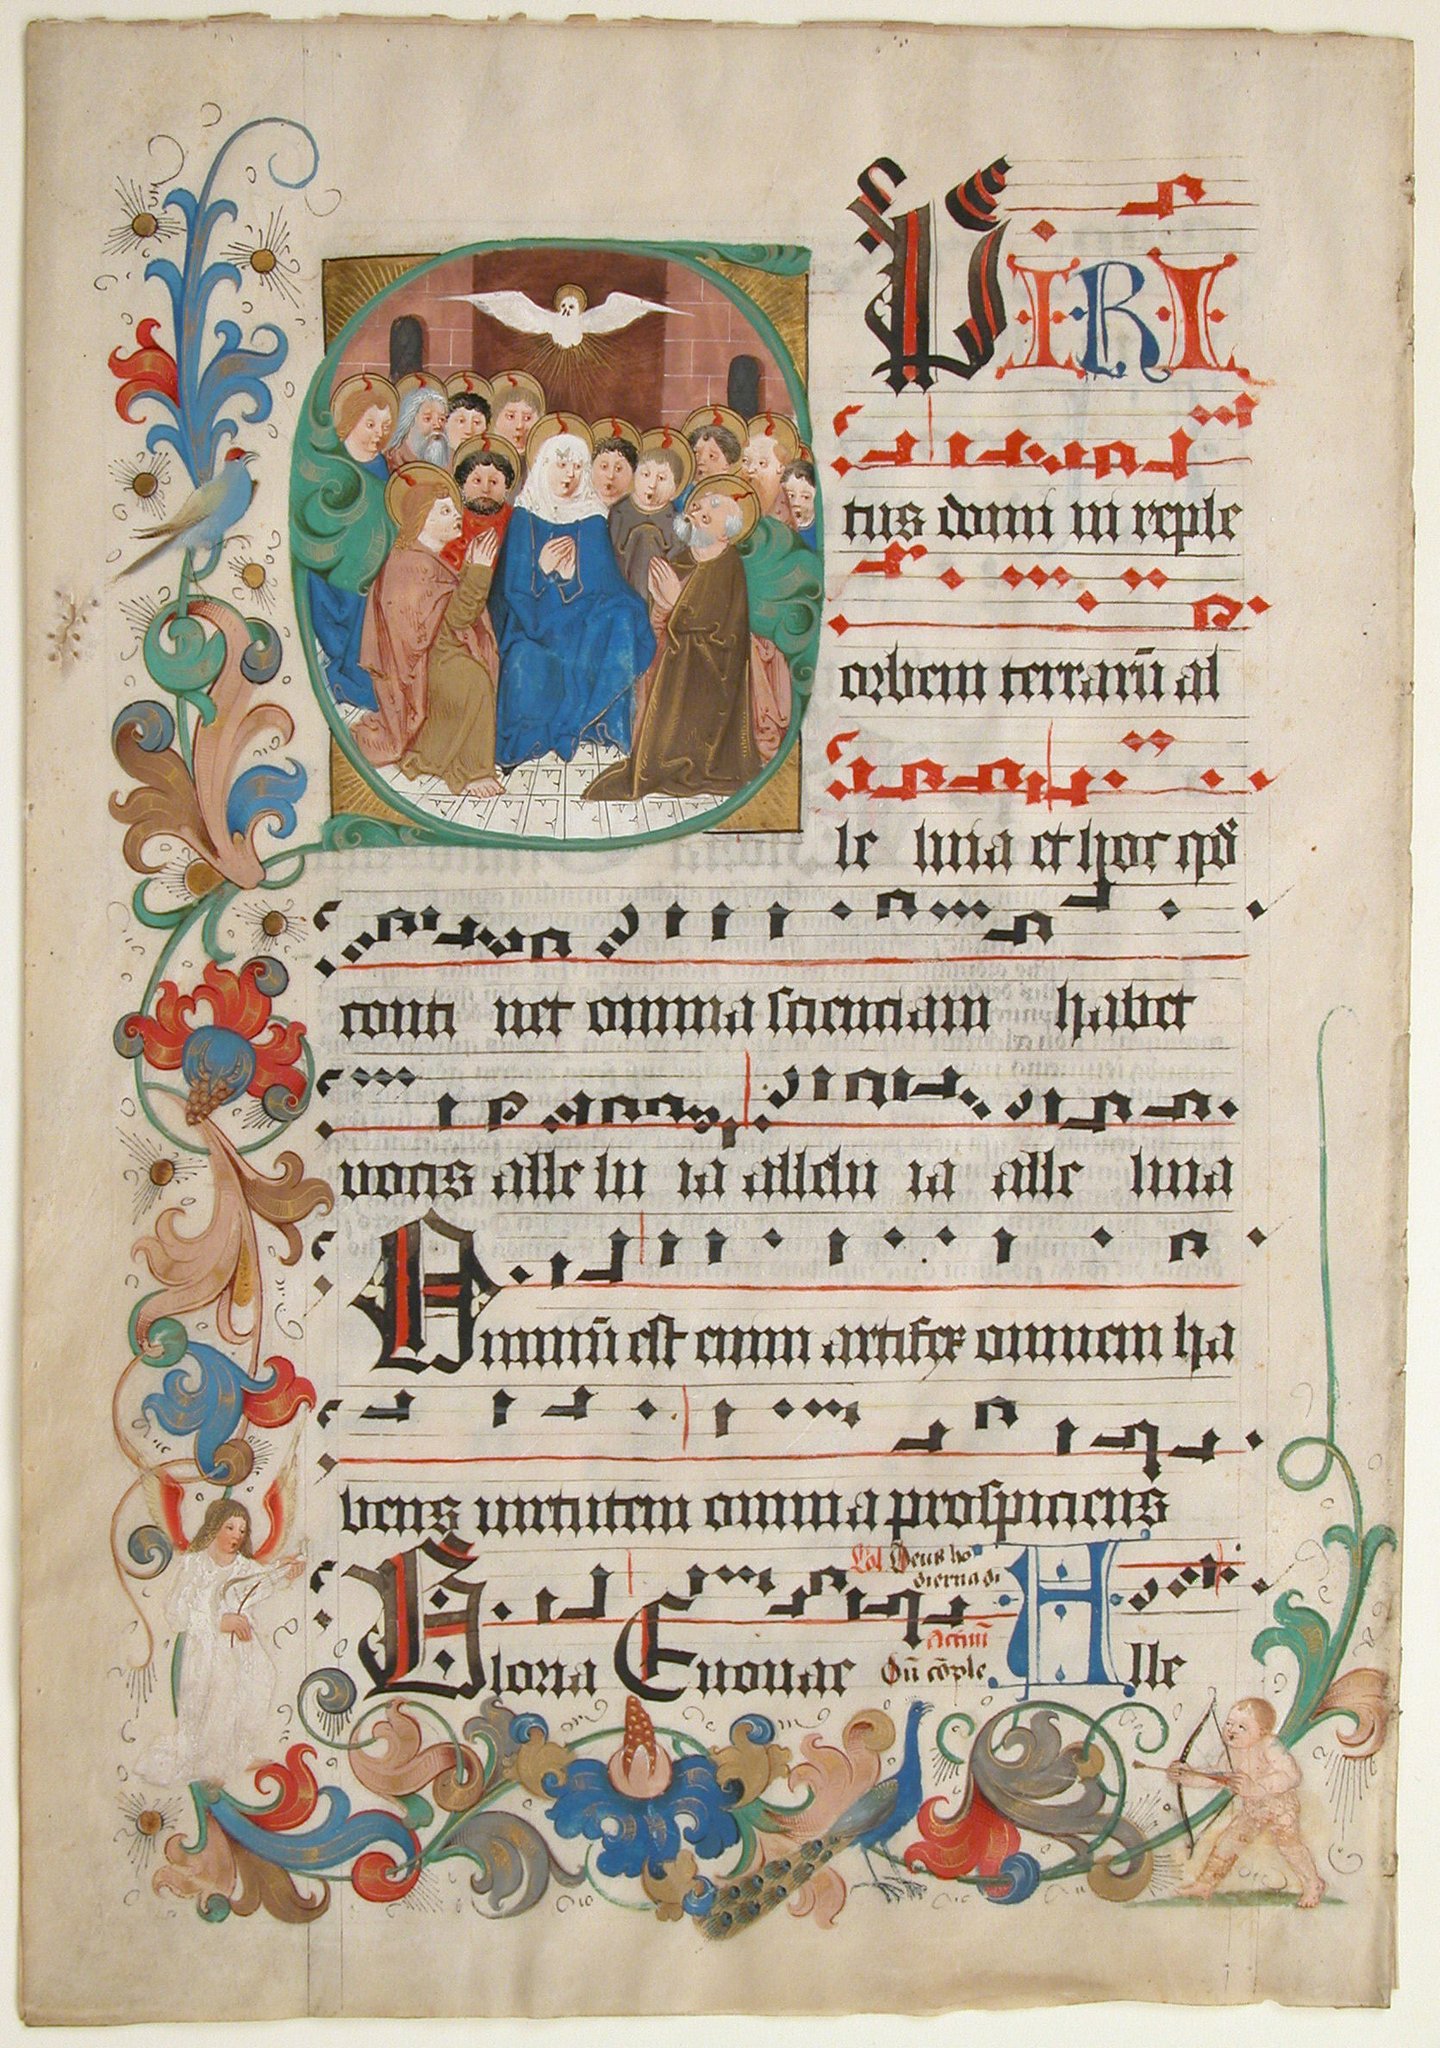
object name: gradual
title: Bifolium from a Gradual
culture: german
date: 1467-1500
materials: ink, metal leaf, parchment, paint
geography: germany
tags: birds,putti,apostles,virgin mary